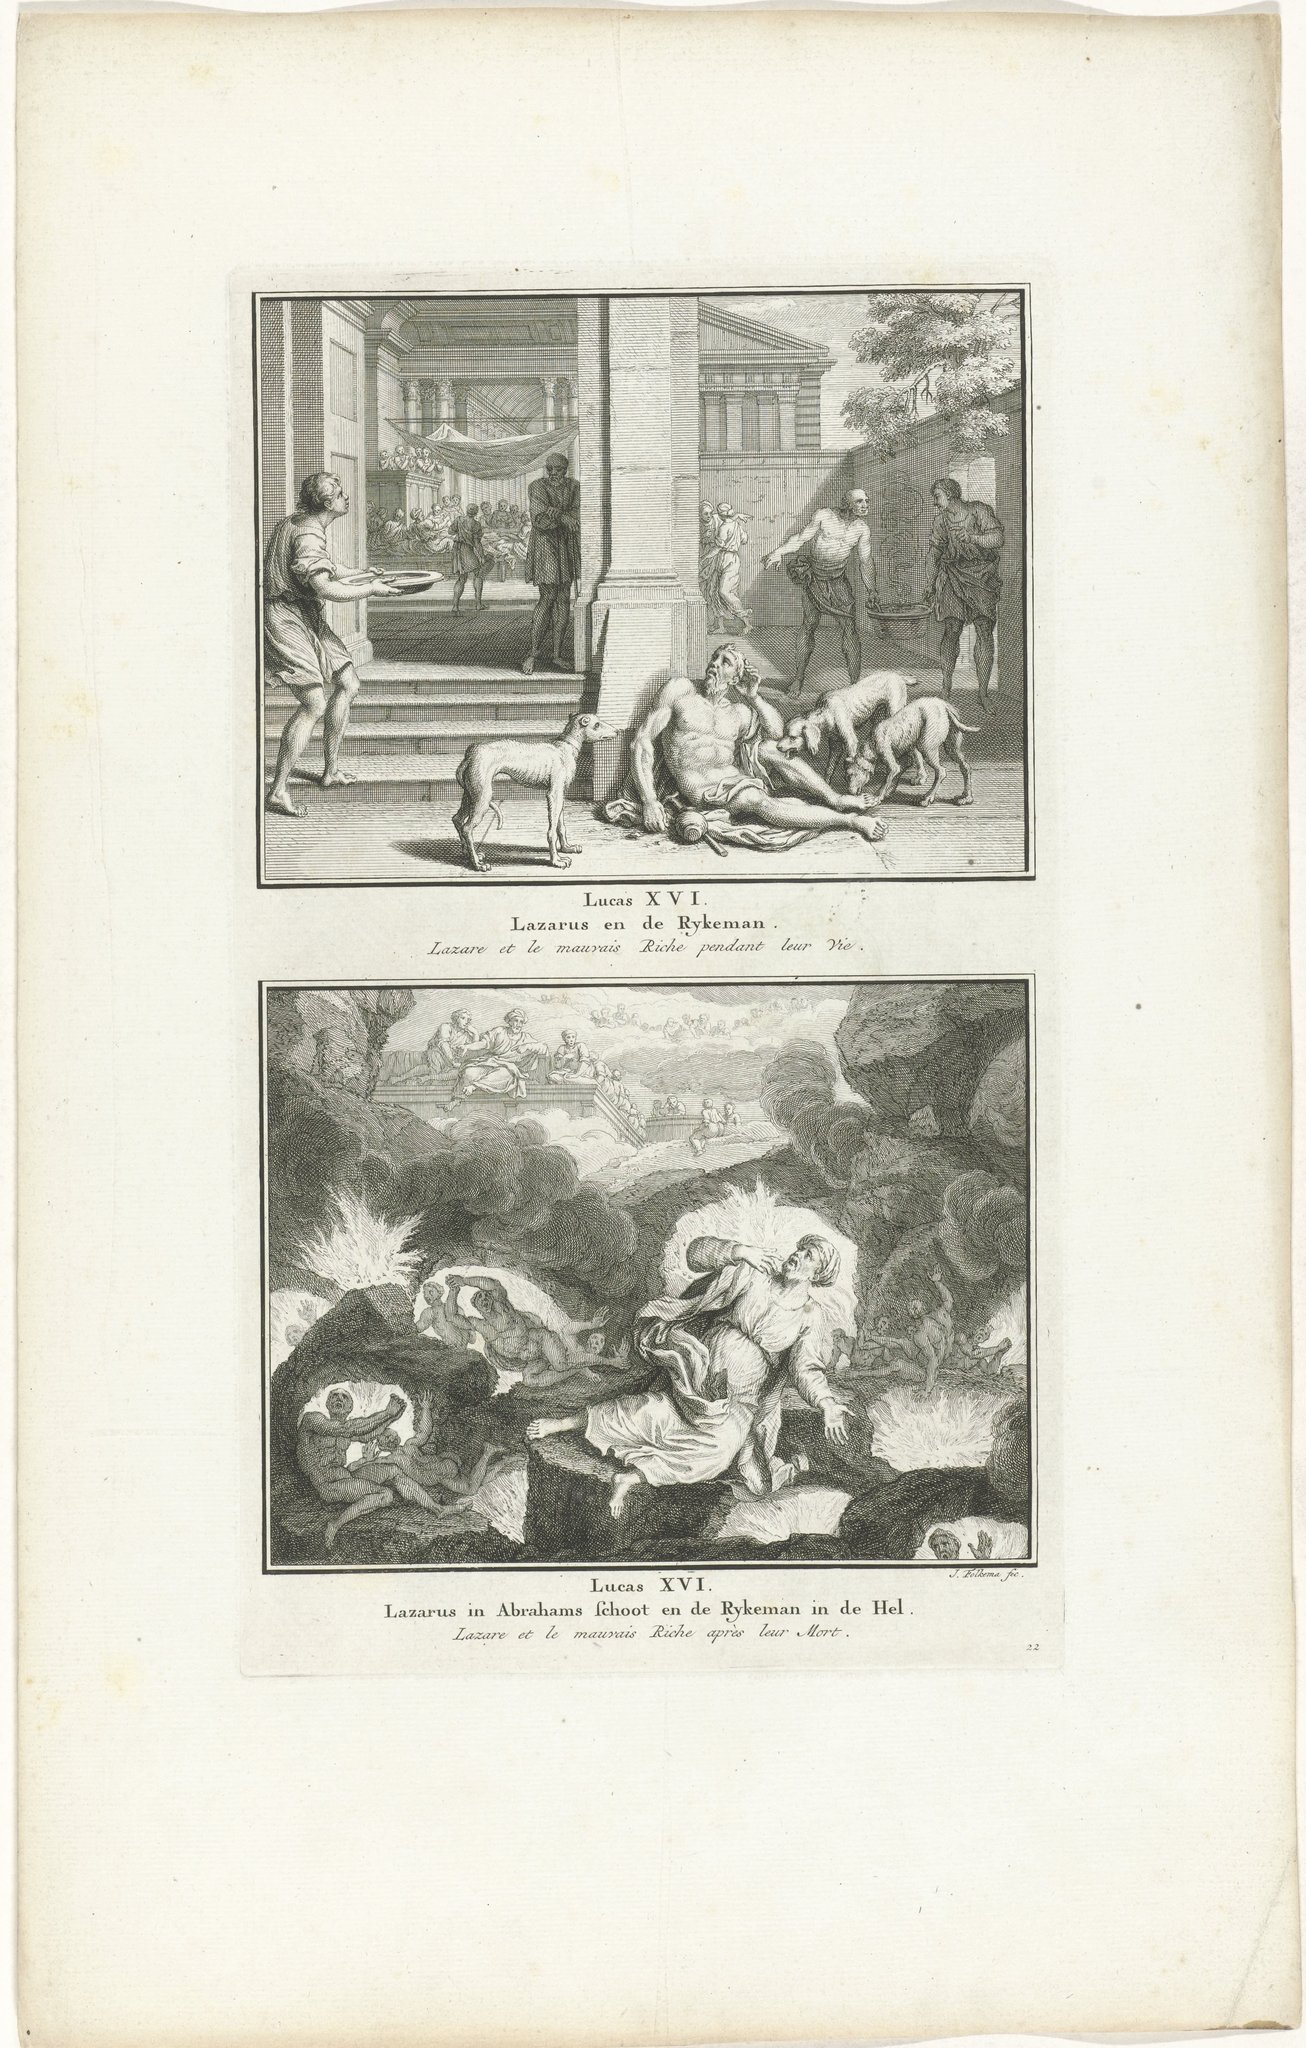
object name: book illustration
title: Lazarus en de rijke man en de rijke man in de hel ziet Abraham met Lazarus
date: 1791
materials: paper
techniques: etching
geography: amsterdam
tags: in hell dives sees lazarus in paradise; usually dives pointing at his tongue, the rich man (dives) is feasting, while poor lazarus is starving at the gate (dogs licking lazarus' sores) (luke 16:19-31)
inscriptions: collector's mark, collector's mark: Lugt 2233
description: Twee Bijbelse voorstellingen uit Luc. 16. De rijke man houdt een feestmaal terwijl de arme Lazarus bij de deur ligt te bedelen, en de rijke man in de hel ziet Abraham met Lazarus. Twee voorstellingen van één plaat, elk voorzien van een titel in het Nederlands en Frans. Geheel rechtsonder genummerd: 22.